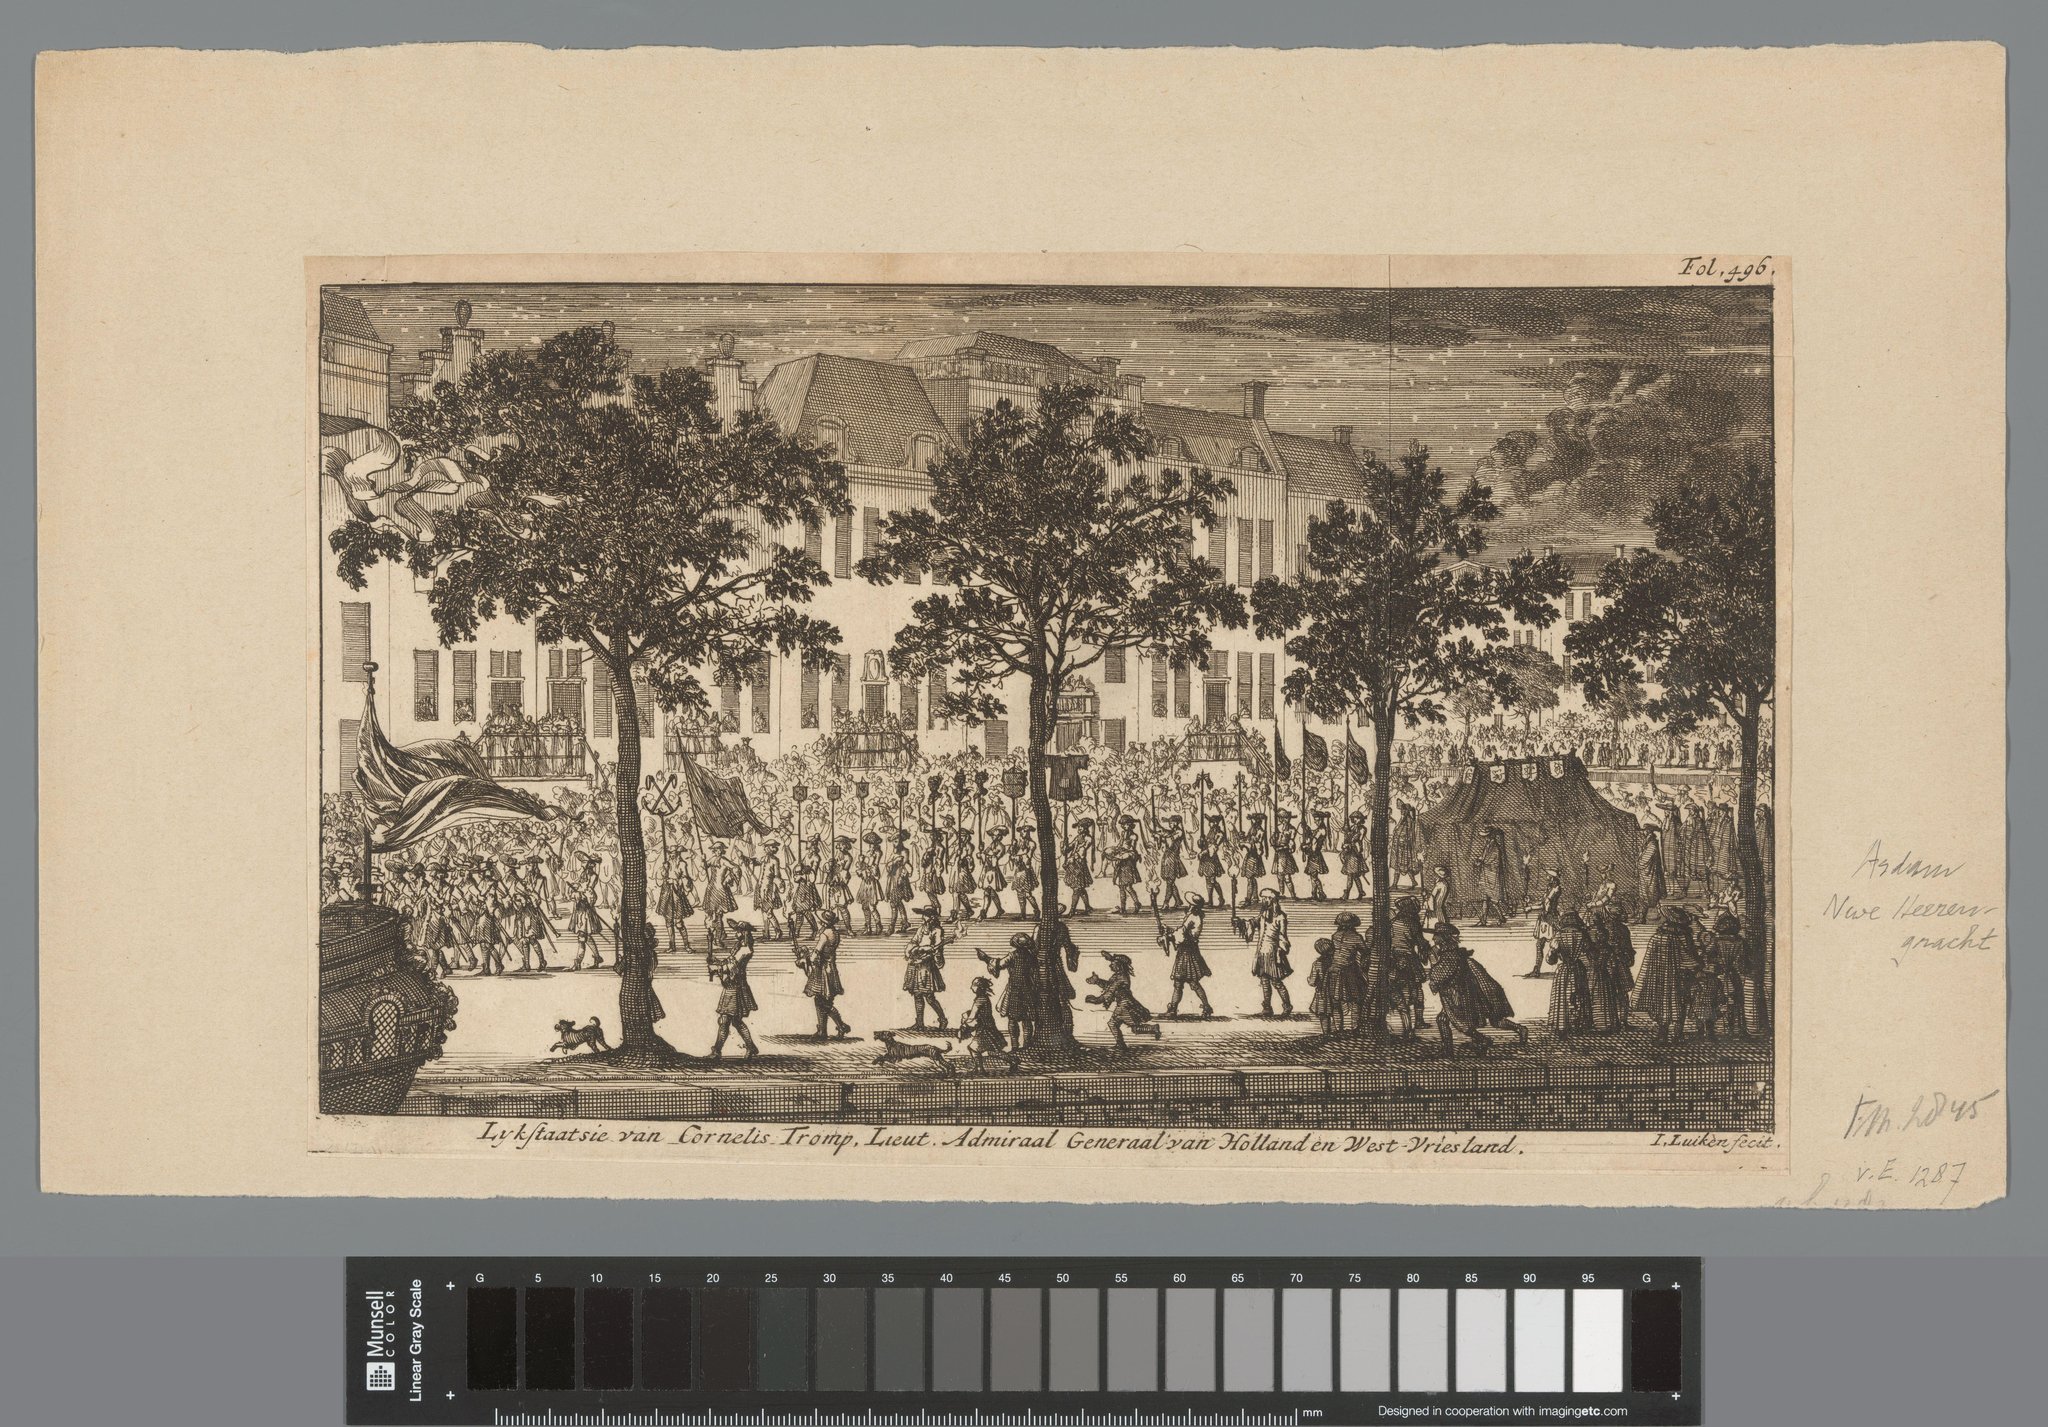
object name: book illustration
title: Lykstaatsie van Cornelis Tromp, Lieut. Admiraal Generaal van Holland en West-Vriesland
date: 1692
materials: paper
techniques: etching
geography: haarlem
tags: rotterdam, amsterdam, cornelis tromp, cortege, funeral procession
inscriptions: collector's mark: Lugt 2228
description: Lijkstatie van admiraal Cornelis Tromp bij nacht langs de Nieuwe Herengracht te Amsterdam naar een jacht die het lichaam naar Delft zou brengen, waarschijnlijk 5 juni 1691. Hij werd op 6 juni in Delft bijgezet. Prent rechtsboven: Fol. 496.